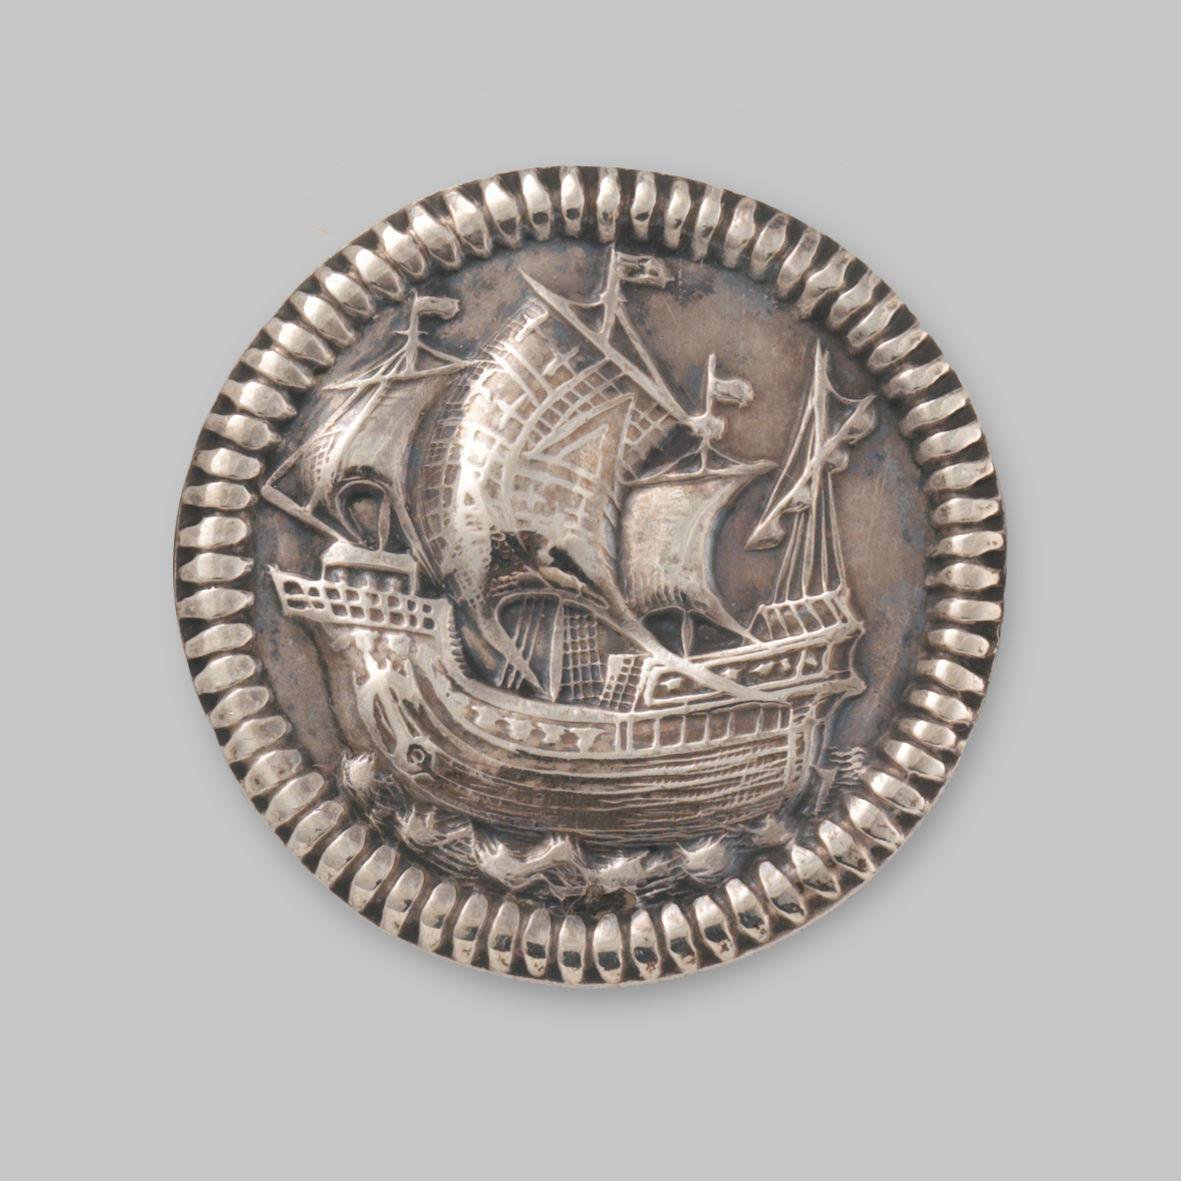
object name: button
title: Knoop met voorstelling van een driemaster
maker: Anonymous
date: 1850-1900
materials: silver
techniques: casting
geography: netherlands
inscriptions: alloy mark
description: Knoop van gegoten zilver, rond, met op de voorzijde een driemaster omgeven door een geribde rand. Aan de achterzijde is een uit gebogen draad vervaardigd oog bevestigd.